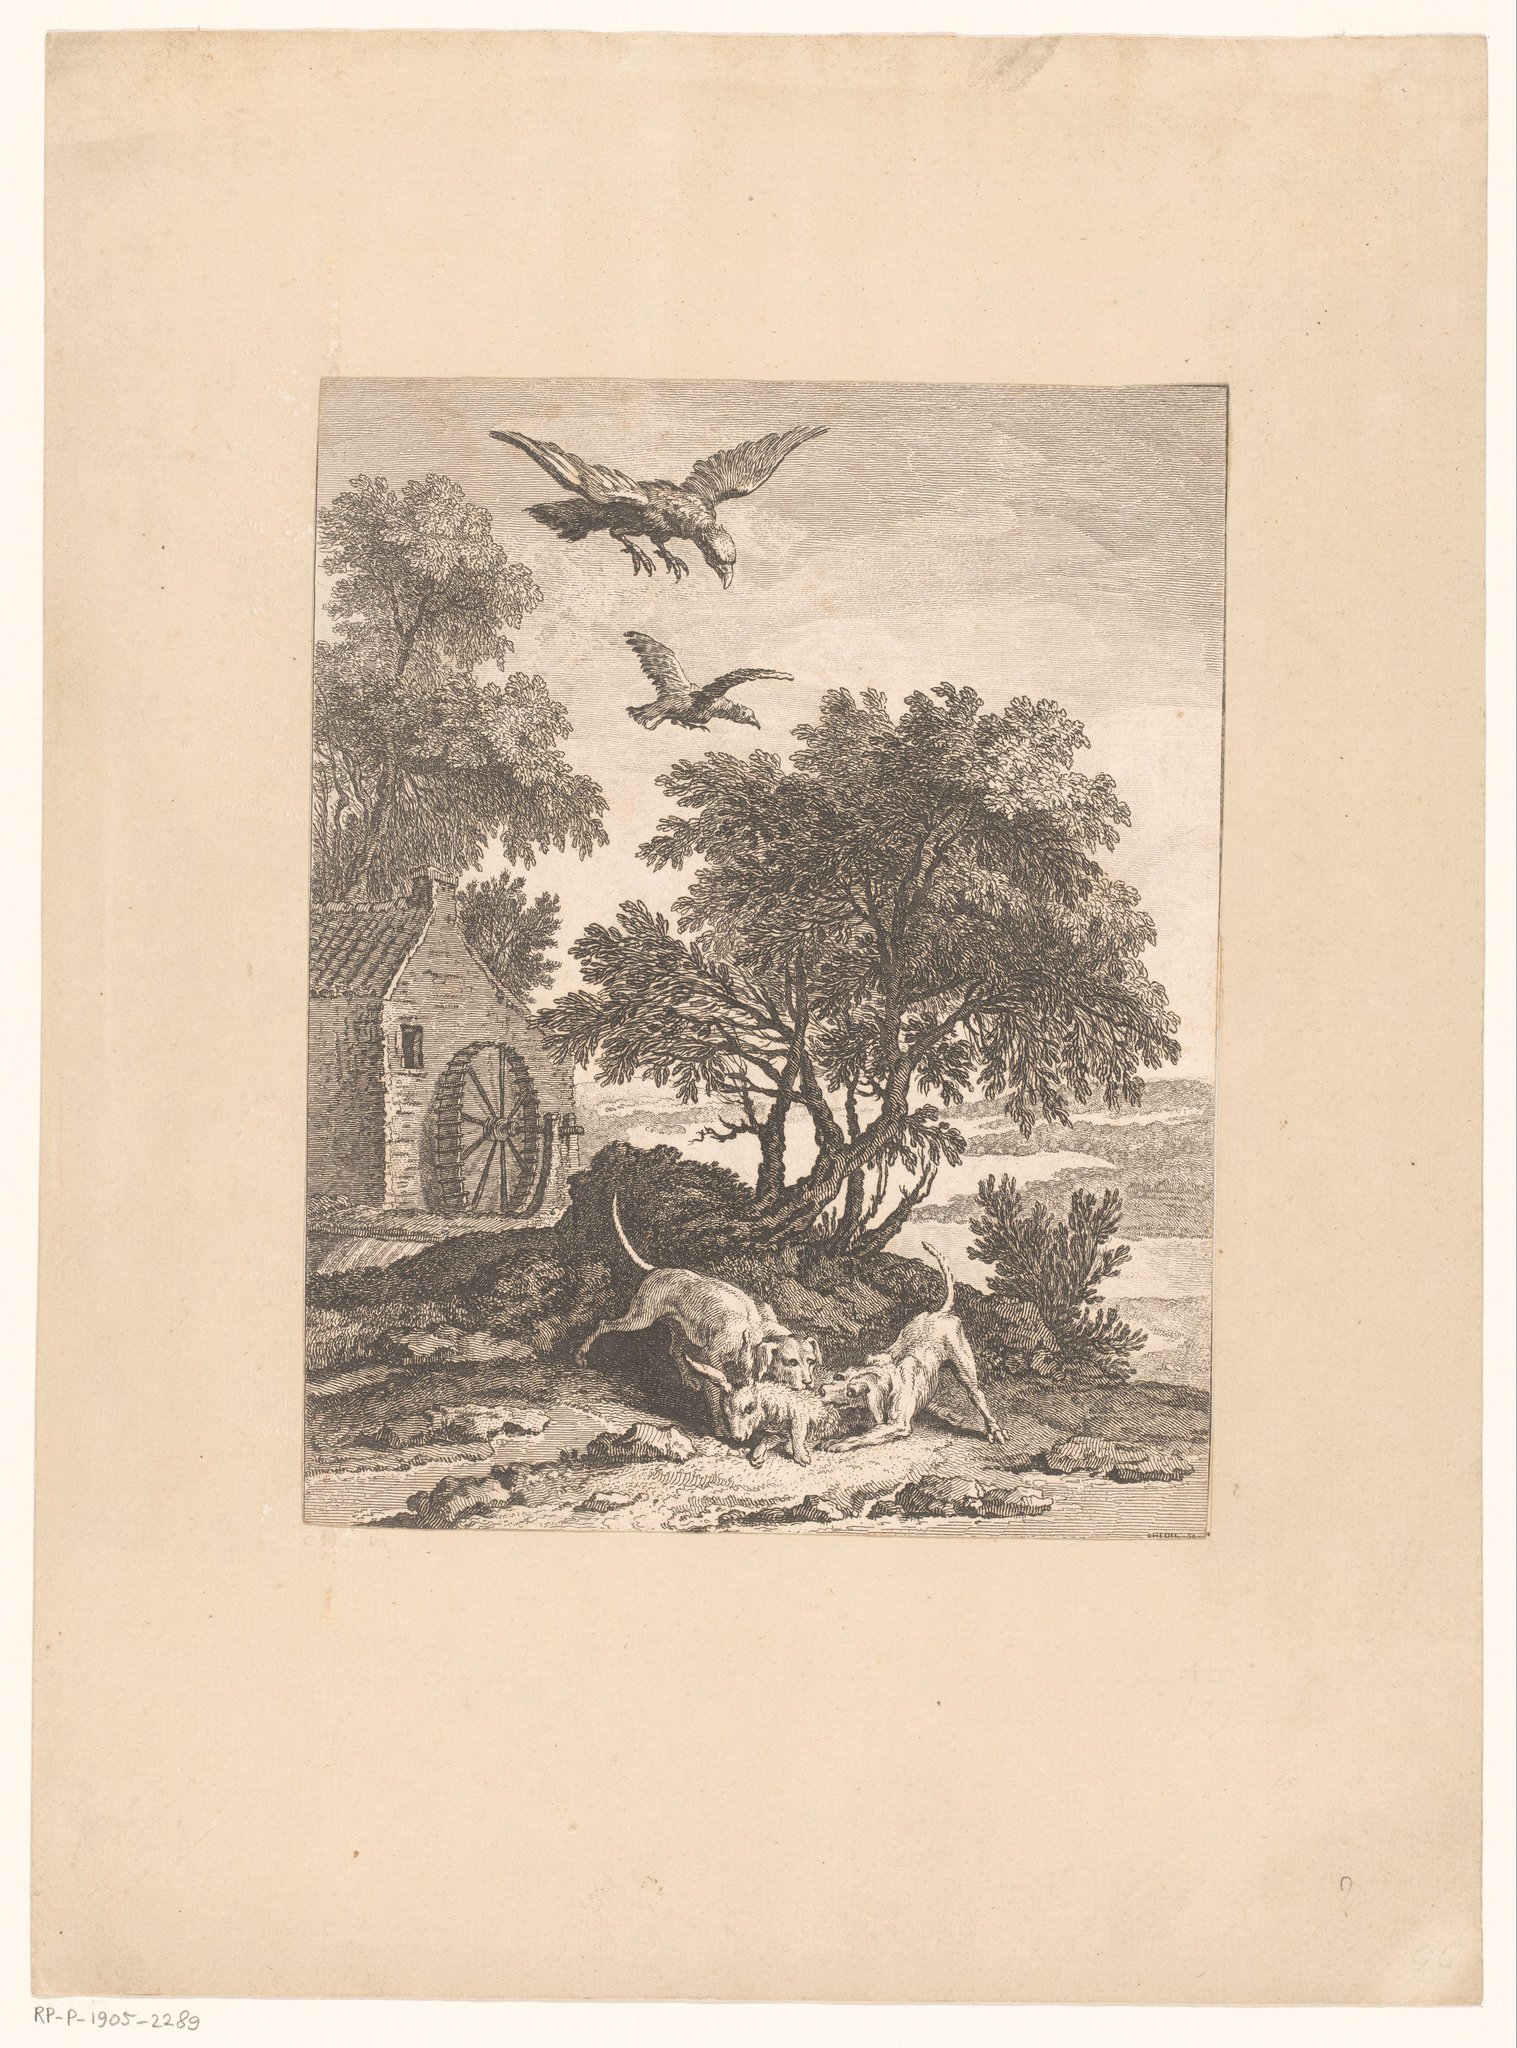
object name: print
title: Twee jachthonden met een haas bij een watermolen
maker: pierre quentin chedel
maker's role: draughtsman, print maker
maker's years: 1705-1763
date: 1715-1763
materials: paper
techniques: etching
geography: france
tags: hunting dogs, rodents: hare, bird hunting, watermill in landscape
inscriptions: collector's mark: Lugt 2228